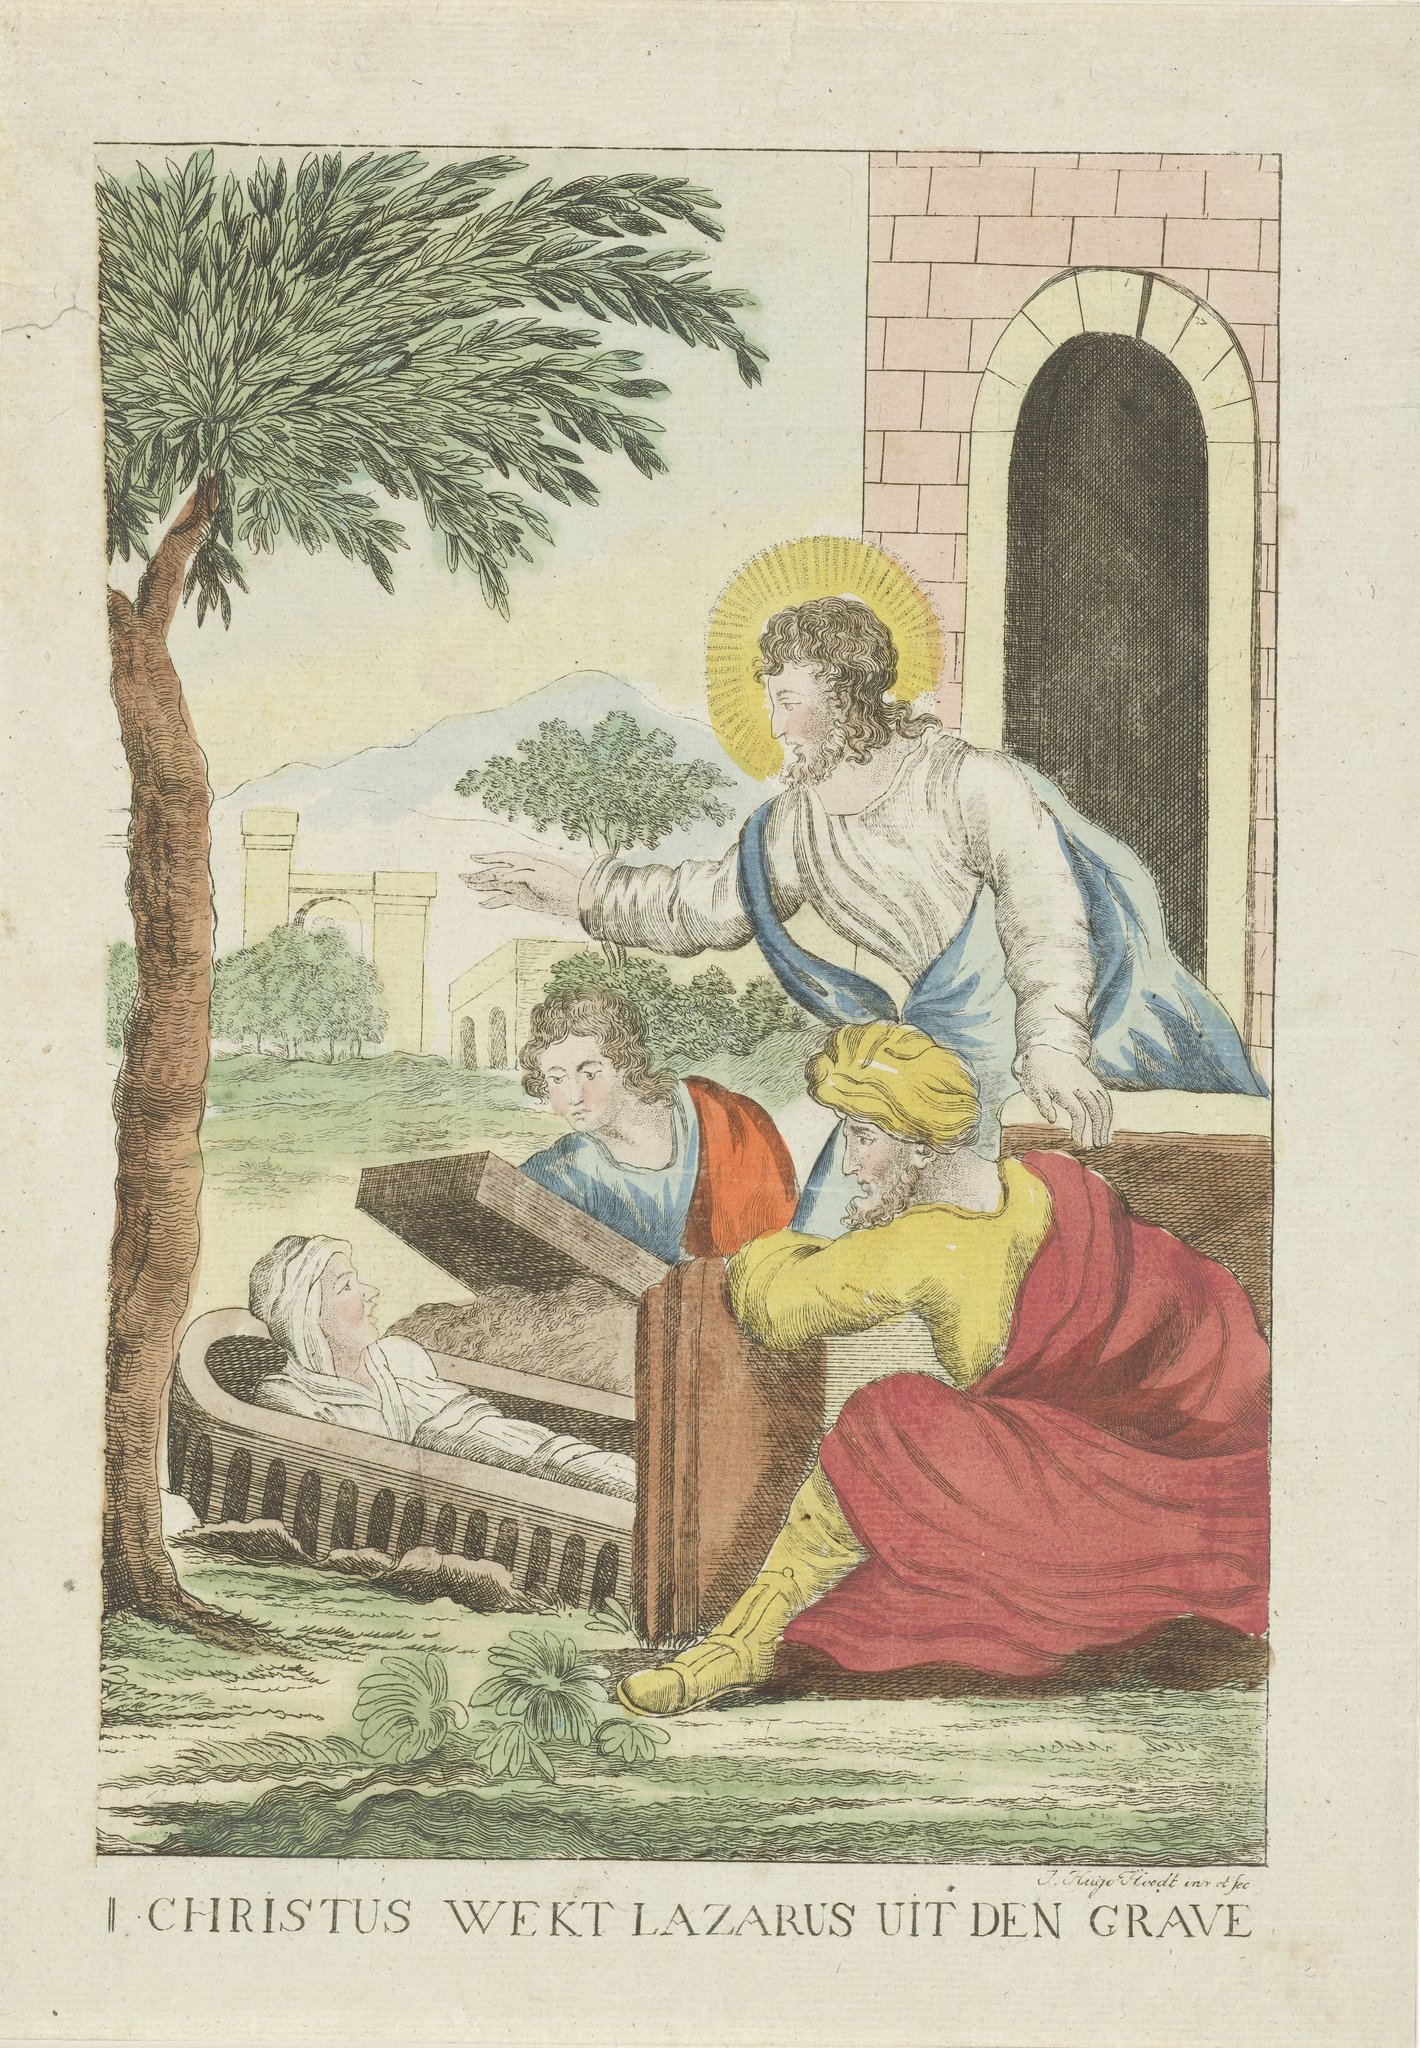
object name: print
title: Christus wekt Lazarus uit den grave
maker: jacob hugo hoedt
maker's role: print maker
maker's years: 1775-1826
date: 1785-1826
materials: paper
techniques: etching, hand coloring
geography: rotterdam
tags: the raising of lazarus ('lazarus, come out')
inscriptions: collector's mark: Lugt 2228, collector's mark: Lugt 2760